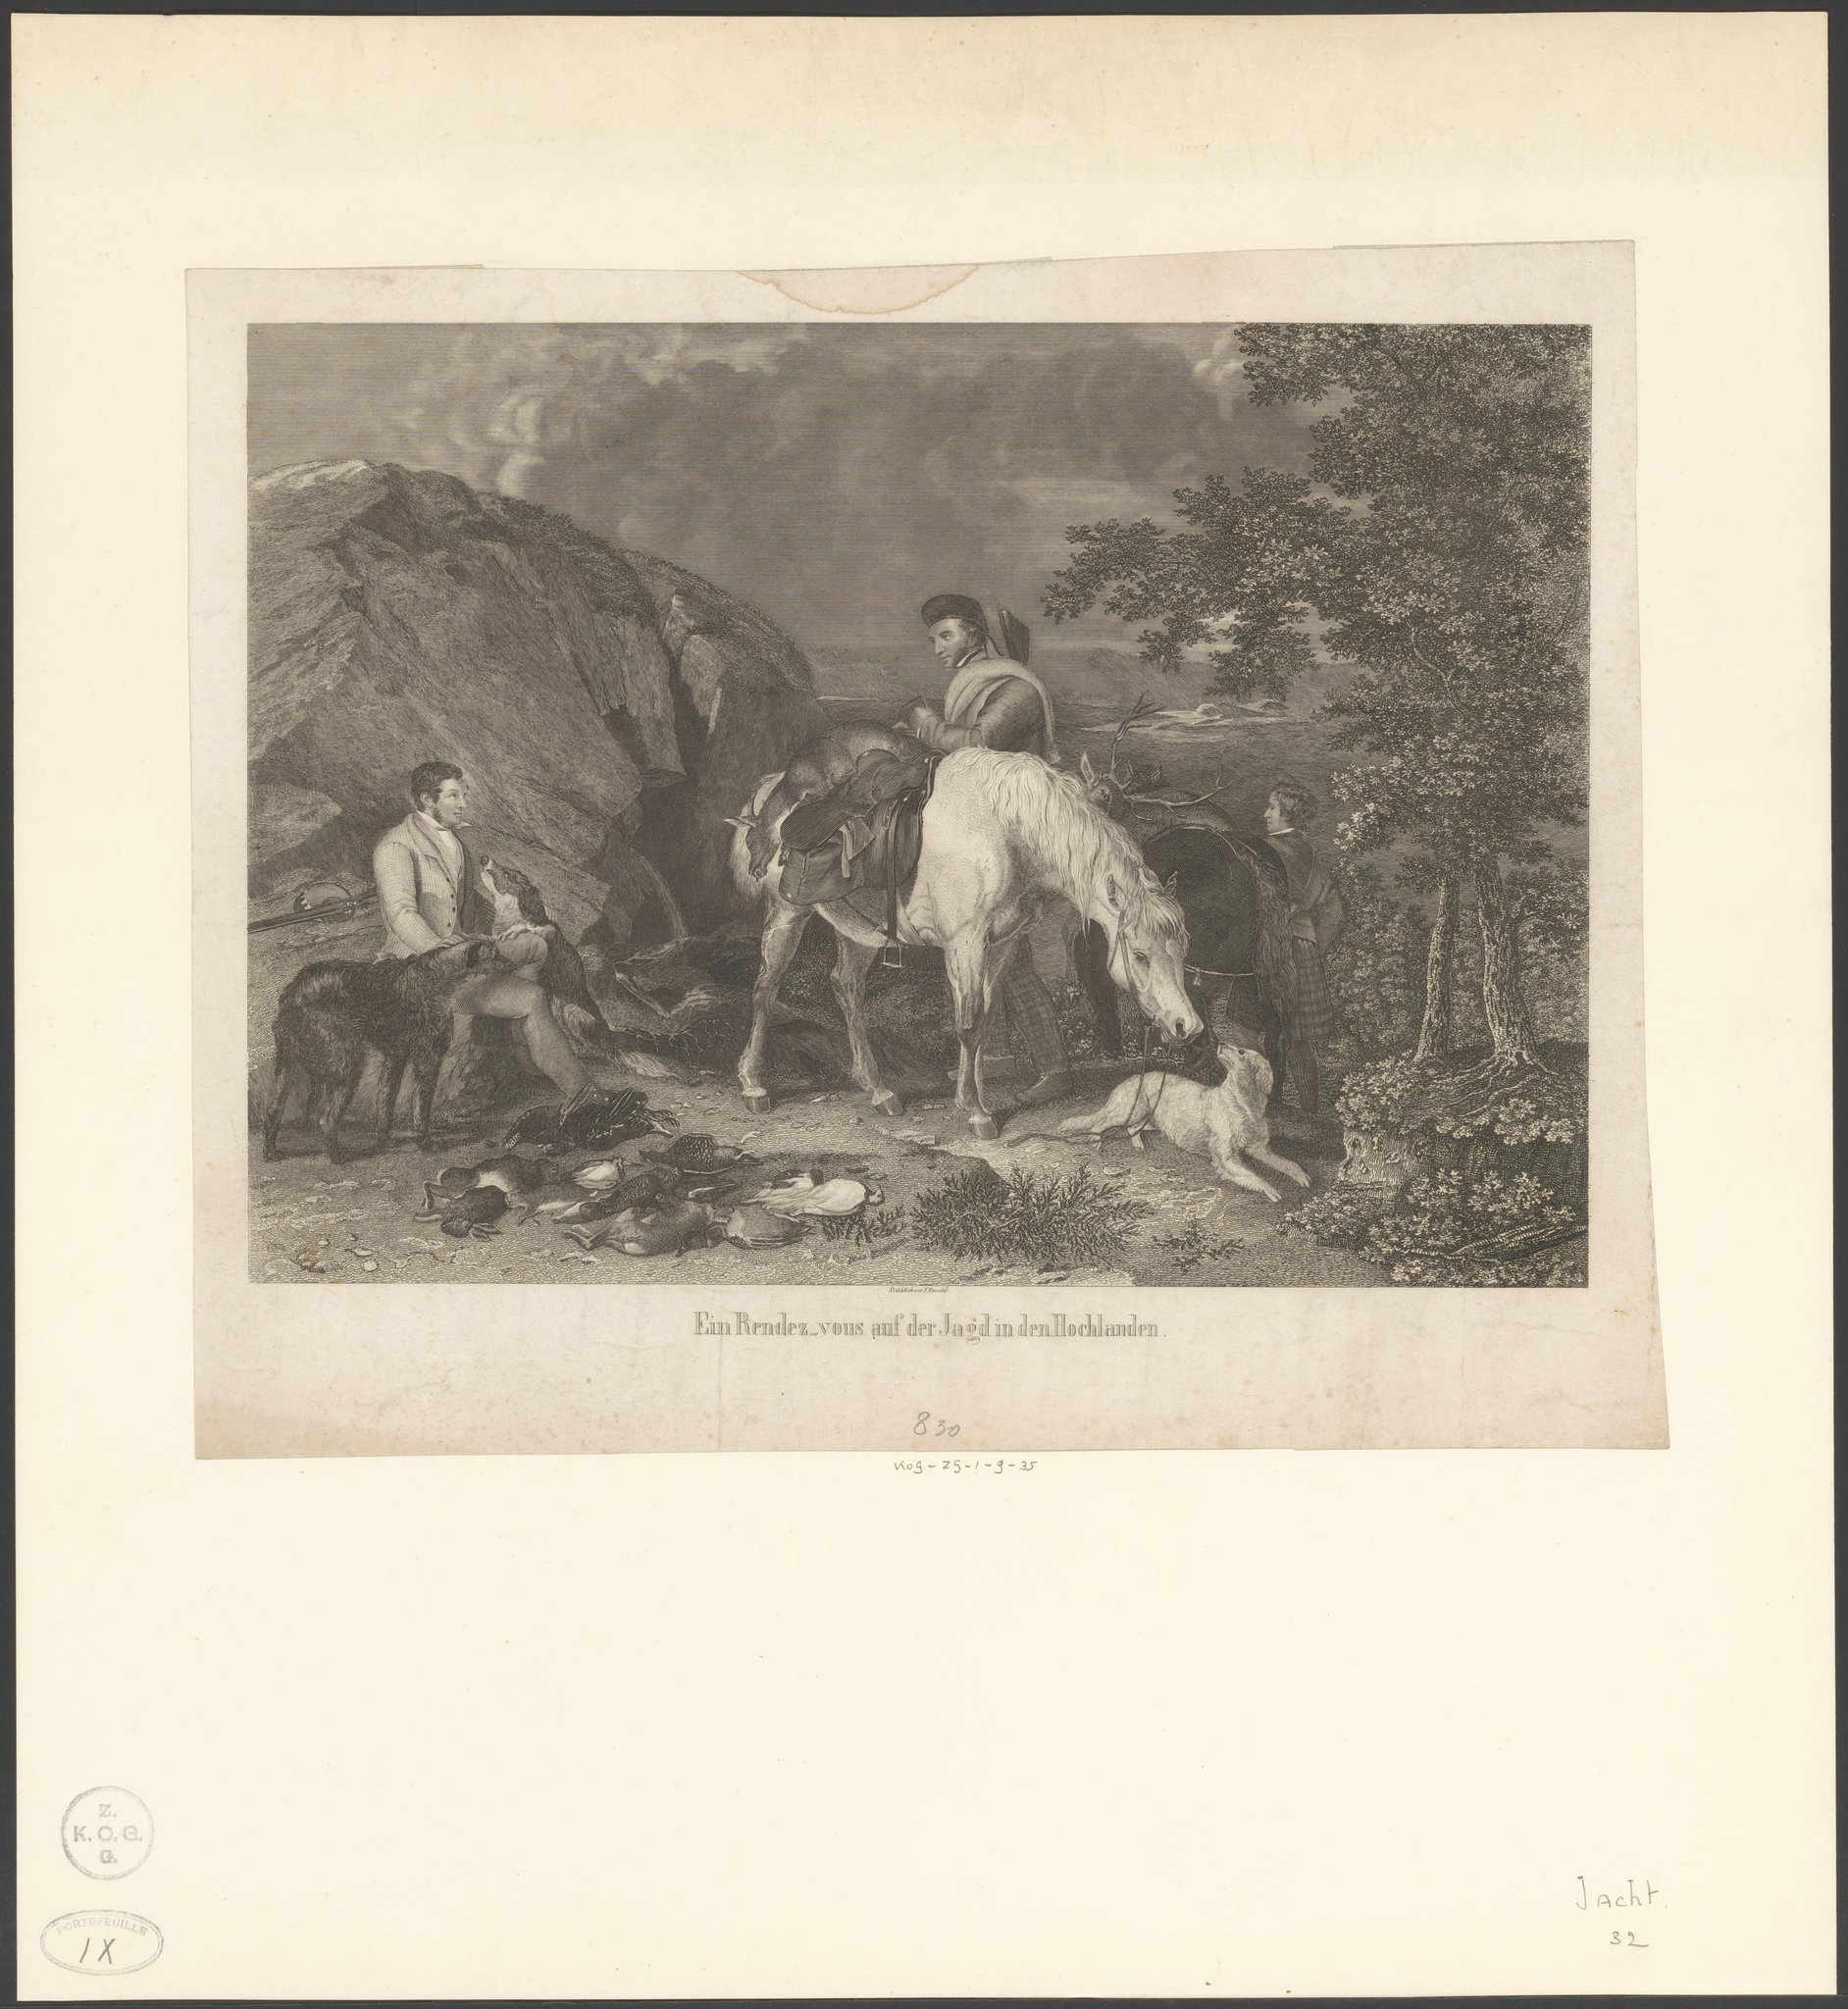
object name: print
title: Ein Rendez-vous auf der Jagd in den Hochlanden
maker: friedrich randel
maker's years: 1808-1886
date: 1818-1886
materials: paper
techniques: engraving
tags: hunter, game, hunted animals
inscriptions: stamp, collector's mark: Lugt 1641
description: Onderwerpsrubrieken binnen de Atlas Zeden en Gewoonten: Handel, nijverheid en verkeer, jacht.